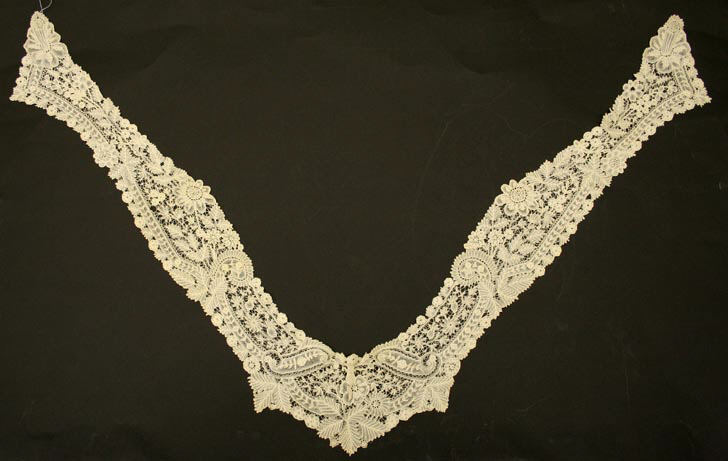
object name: lappet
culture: belgian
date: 1867-1933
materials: linen